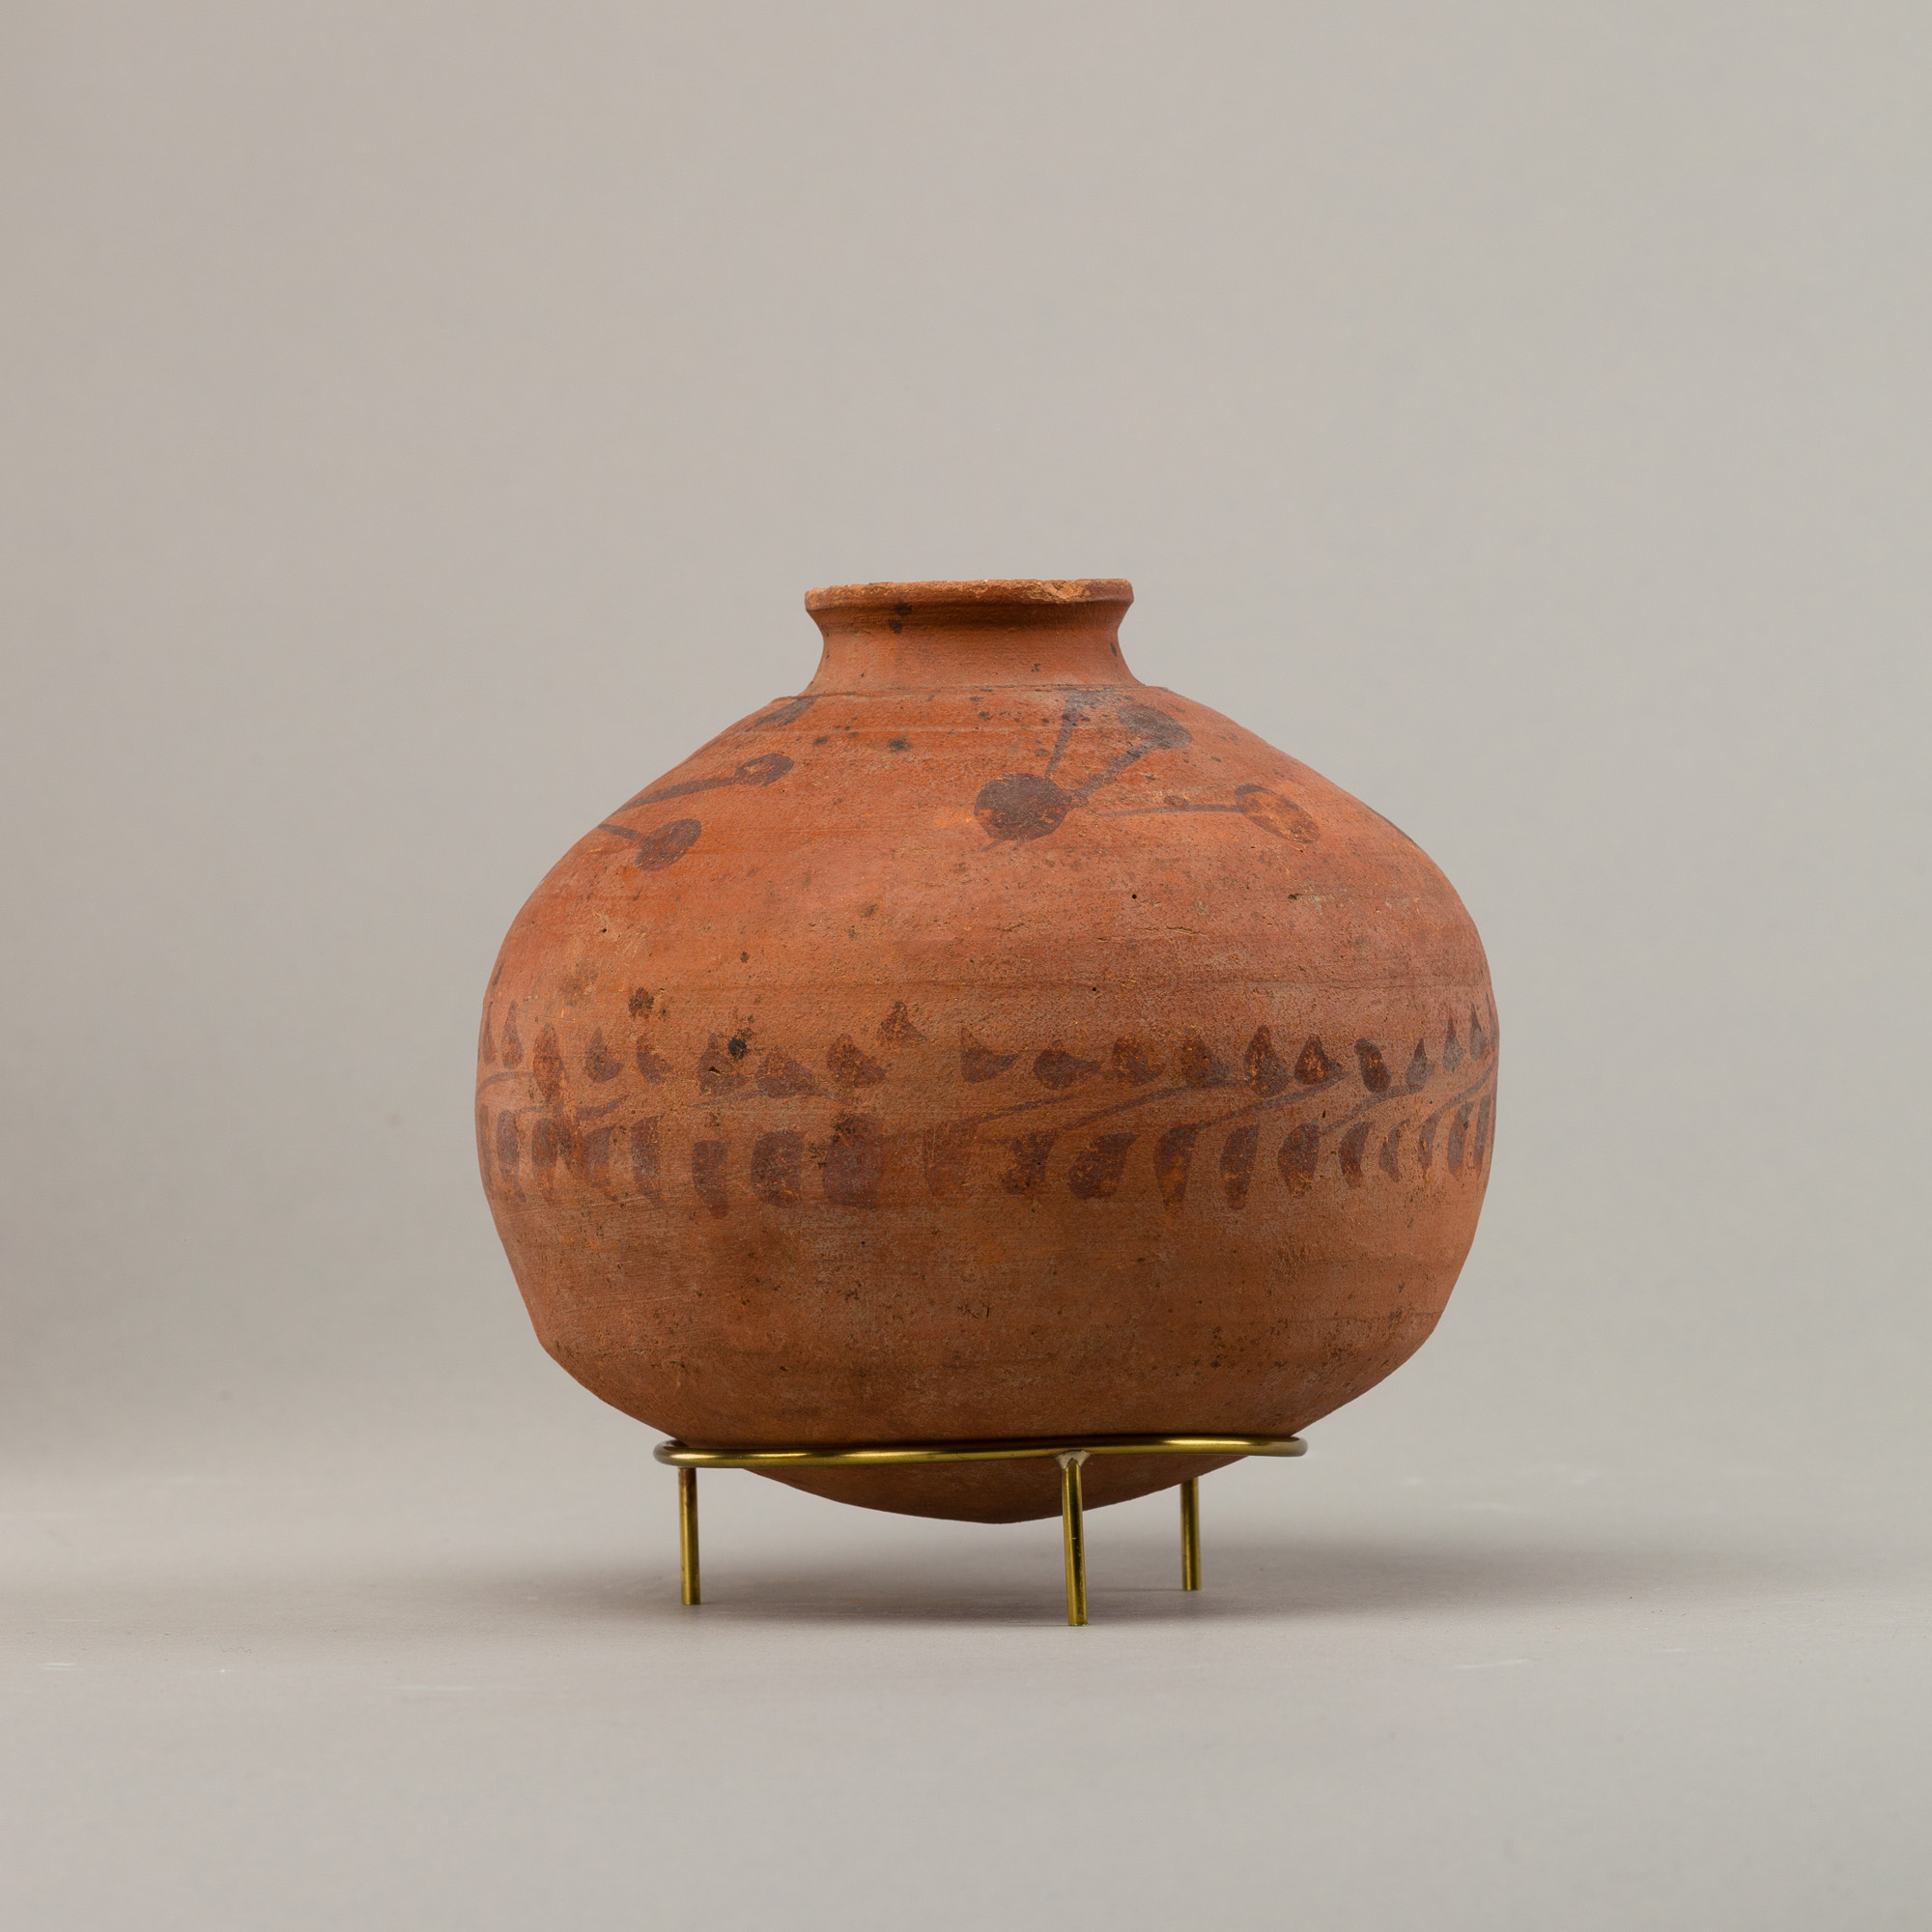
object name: jar, vine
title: Jar with painted vines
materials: paint, pottery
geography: egypt and sudan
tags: vines